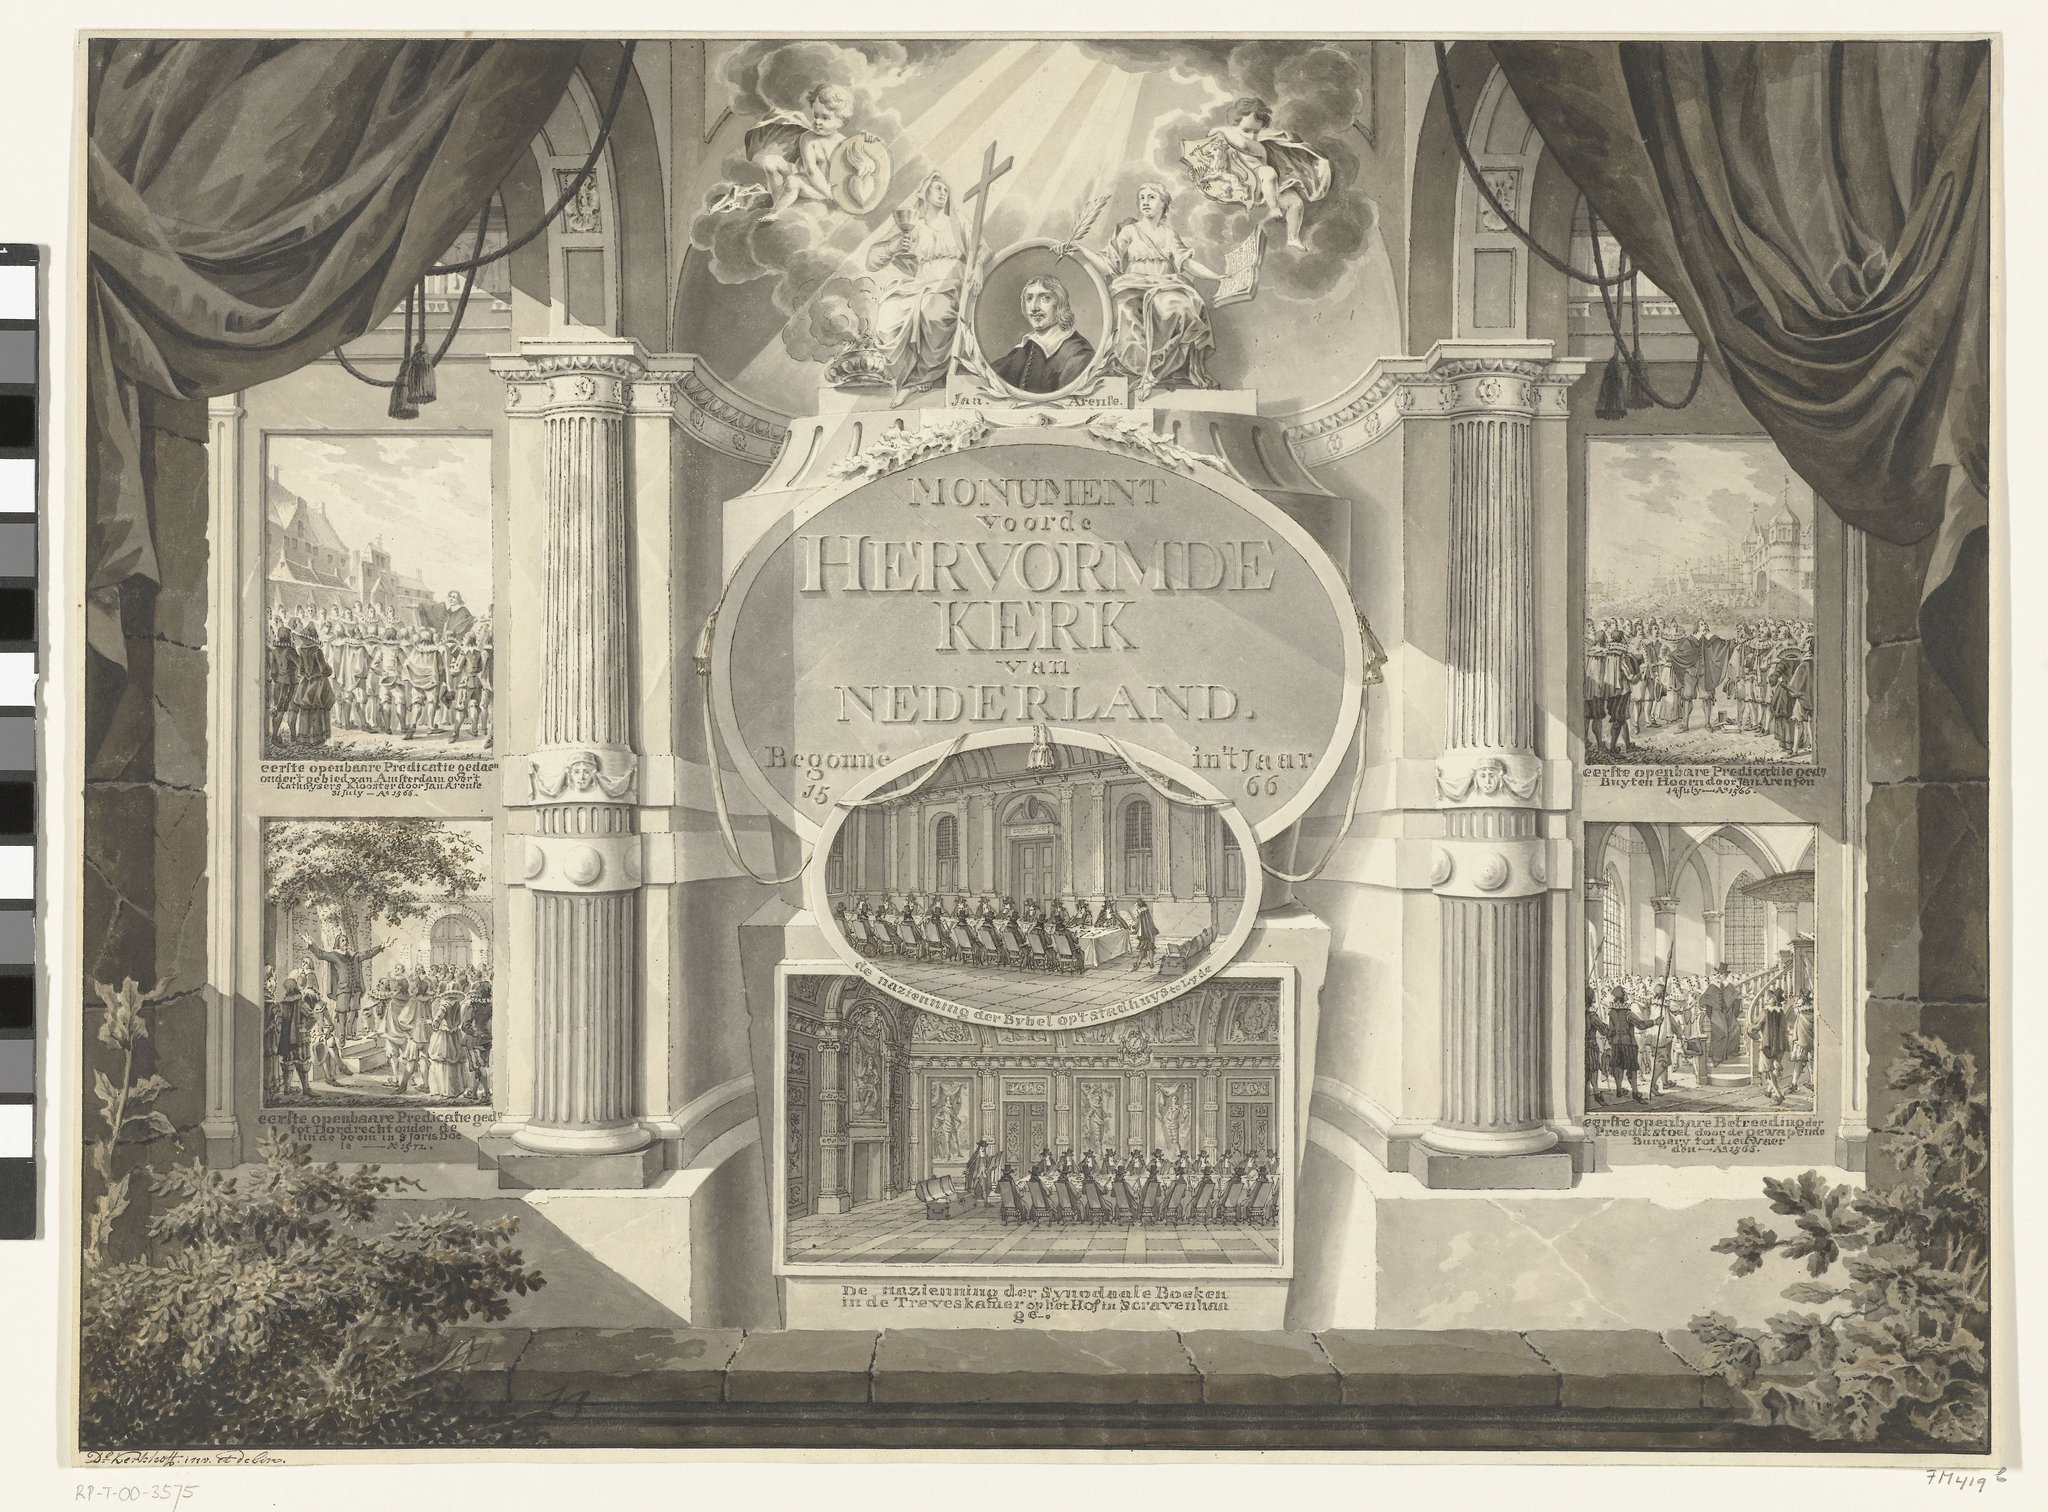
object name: drawing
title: Monument voor de Hervormde Kerk van Nederland. Begonne in't Jaar 1566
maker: daniël kerkhoff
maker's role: draughtsman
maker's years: 1766-1821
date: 1780-1796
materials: ink, paper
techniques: brush, pen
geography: netherlands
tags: reformation (roman catholic church vs. protestantism), preaching (in general), leiden, the hague, dordrecht, amsterdam, hoorn (north holland)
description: Monument voor de Hervormde Kerk van Nederland, vanaf 1566. Boven een klein portret van de eerste lutherse predikant Jan Arentsz, links en rechts scènes van de eerste calvinistische predikingen in de jaren 1566 en 1572 te Amsterdam, Hoorn, Leeuwarden en Dordrecht. In het midden het nazien van de bijbelvertaling te Leiden en Den Haag. Ontwerptekening voor de prent. Zinneprent op de Hervorming.